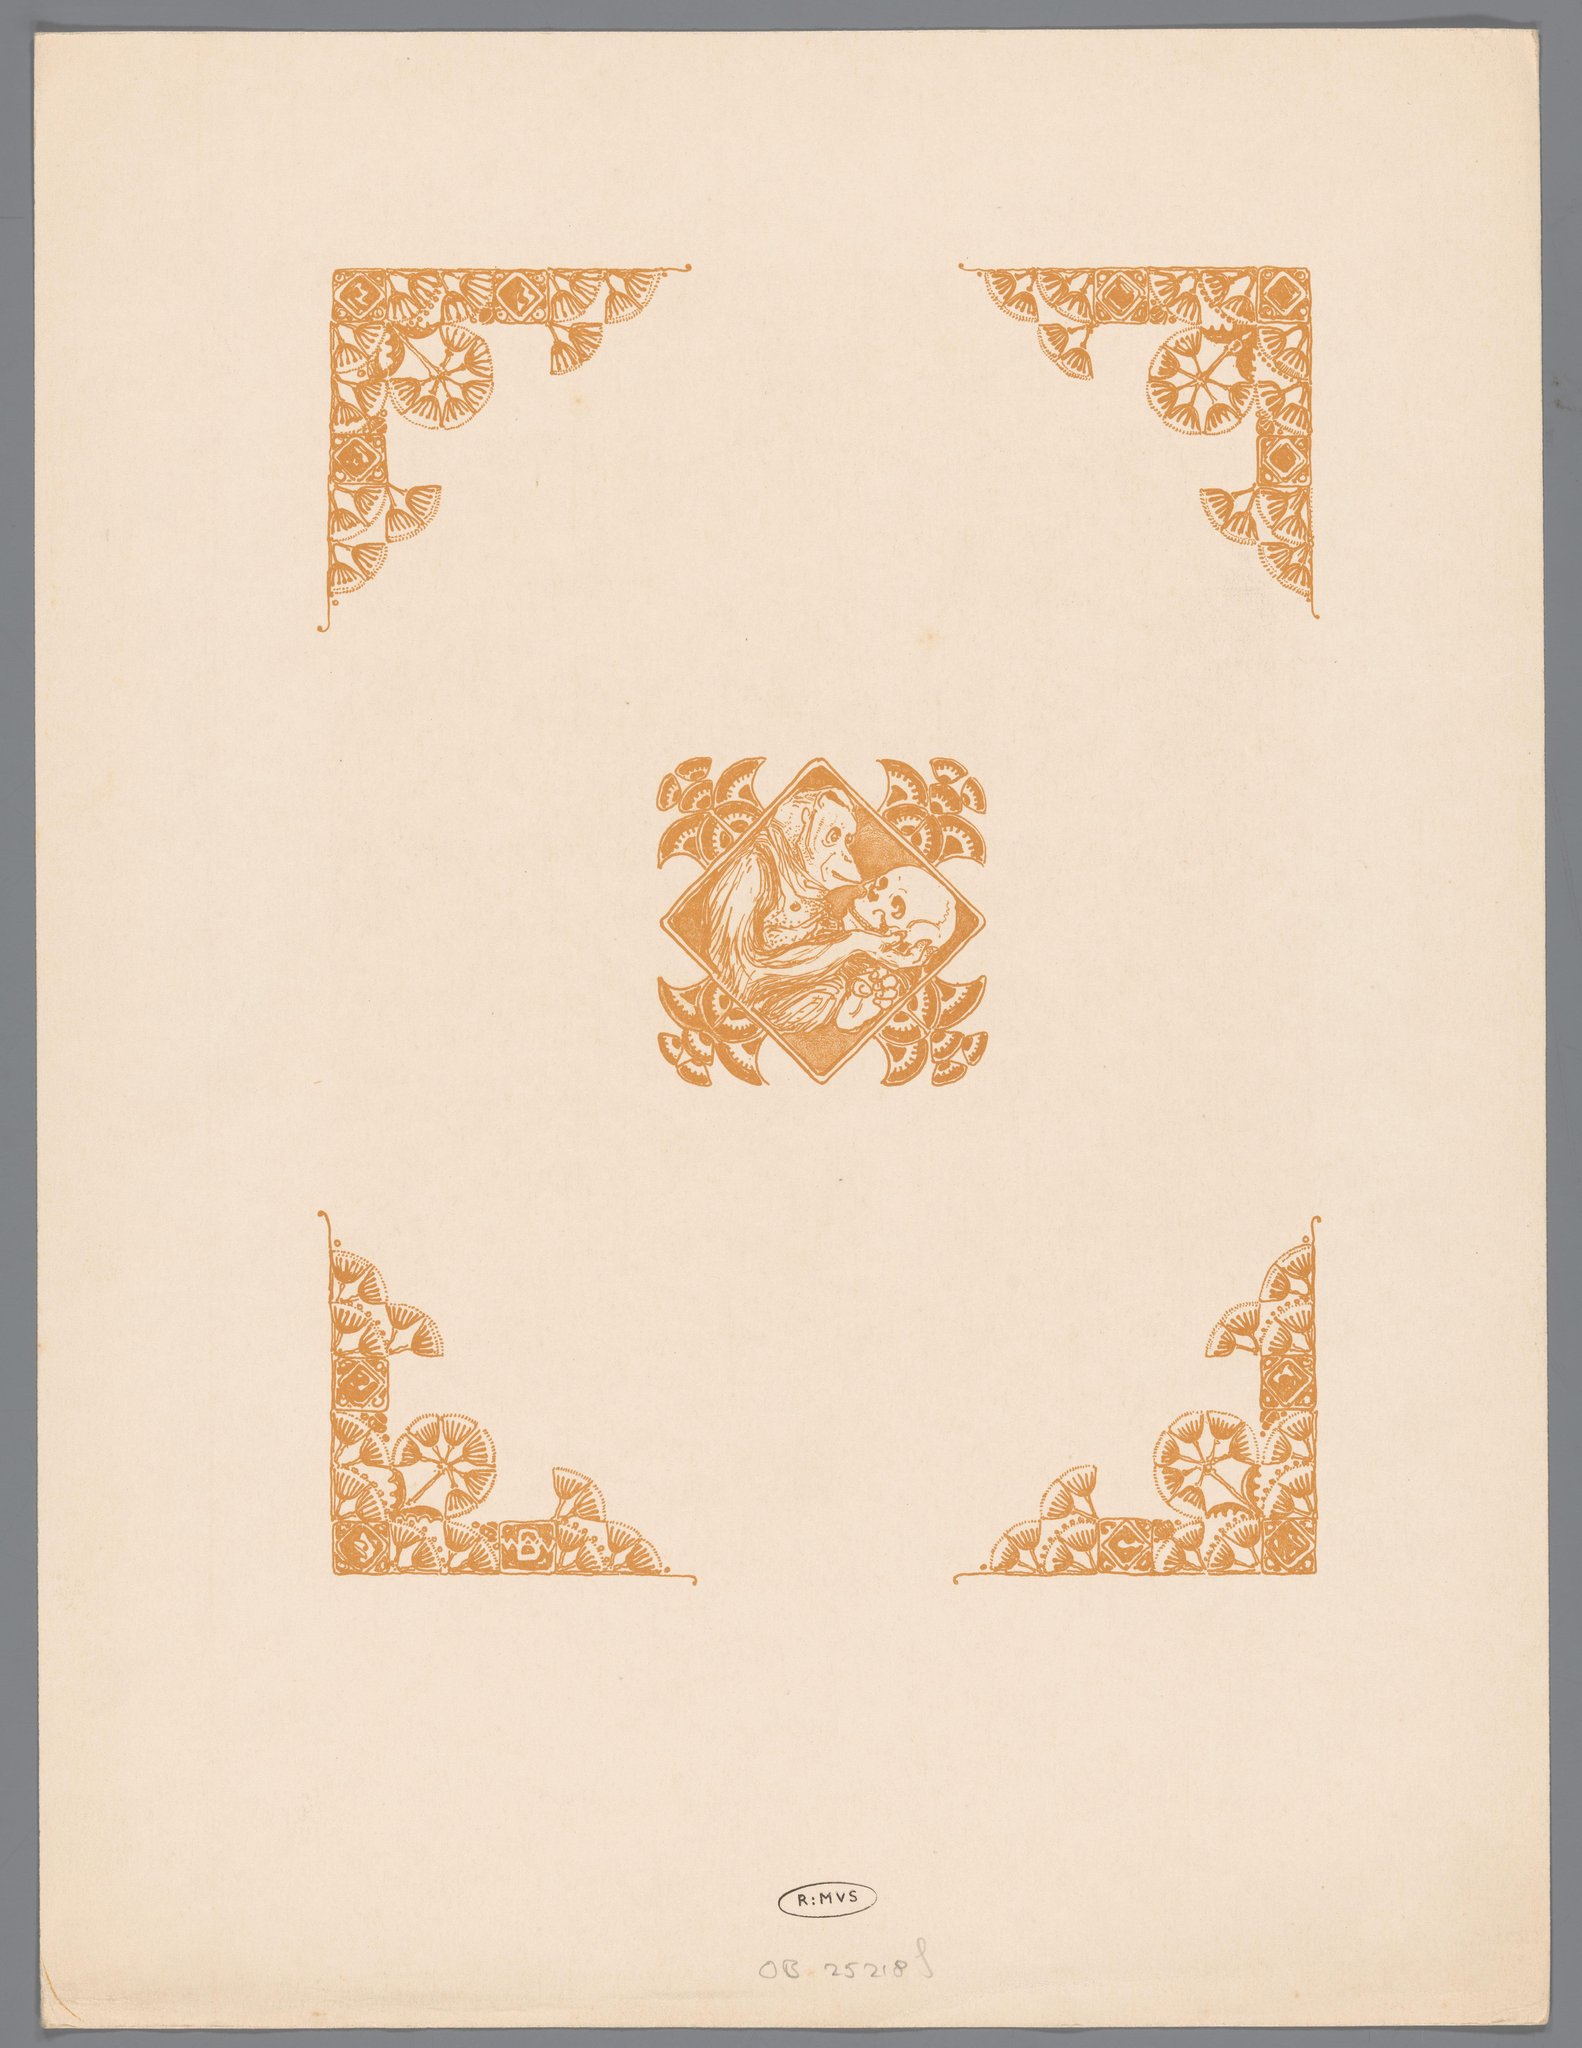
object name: book illustration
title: Ornamentiek en een aap met een schedel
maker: bernard willem wierink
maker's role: draughtsman, print maker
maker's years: 1856-1939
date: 1910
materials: paper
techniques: lithograph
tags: fable of reynard the fox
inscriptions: collector's mark: Lugt 2228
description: Prent gebruikt in: Streuvels, Stijn (Frank Lateur). Reinaert de Vos naar verschillende uitgaven van het middeleeuwsche epos. Amsterdam: L.J. Veen, 1910.